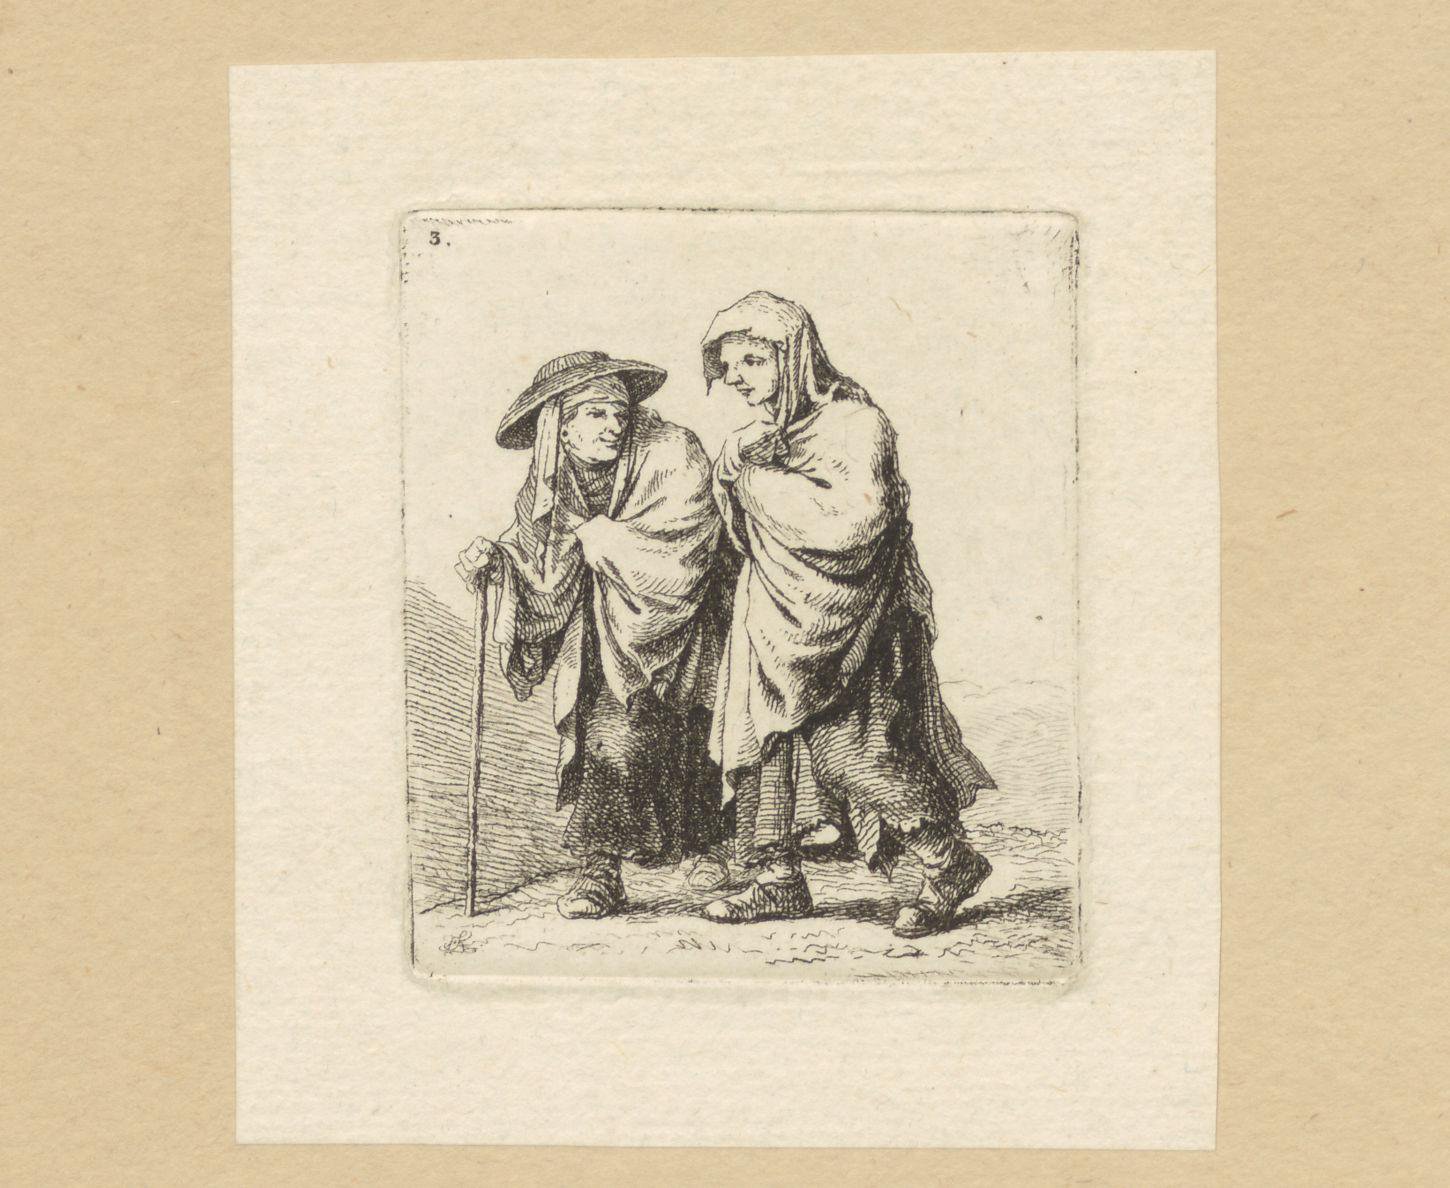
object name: print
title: Etudes D'Apres Nature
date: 1770-1780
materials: paper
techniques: etching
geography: paris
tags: old woman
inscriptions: collector's mark: Lugt 2228, number: ‘3’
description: Deze prent hoort bij een serie van vijf prenten getiteld 'Etudes d'apres nature' door Ferdinand Kobell gemaakt tussen 1770 en 1775 en zijn uitgegeven in Frankrijk door Gottlieb Hess.